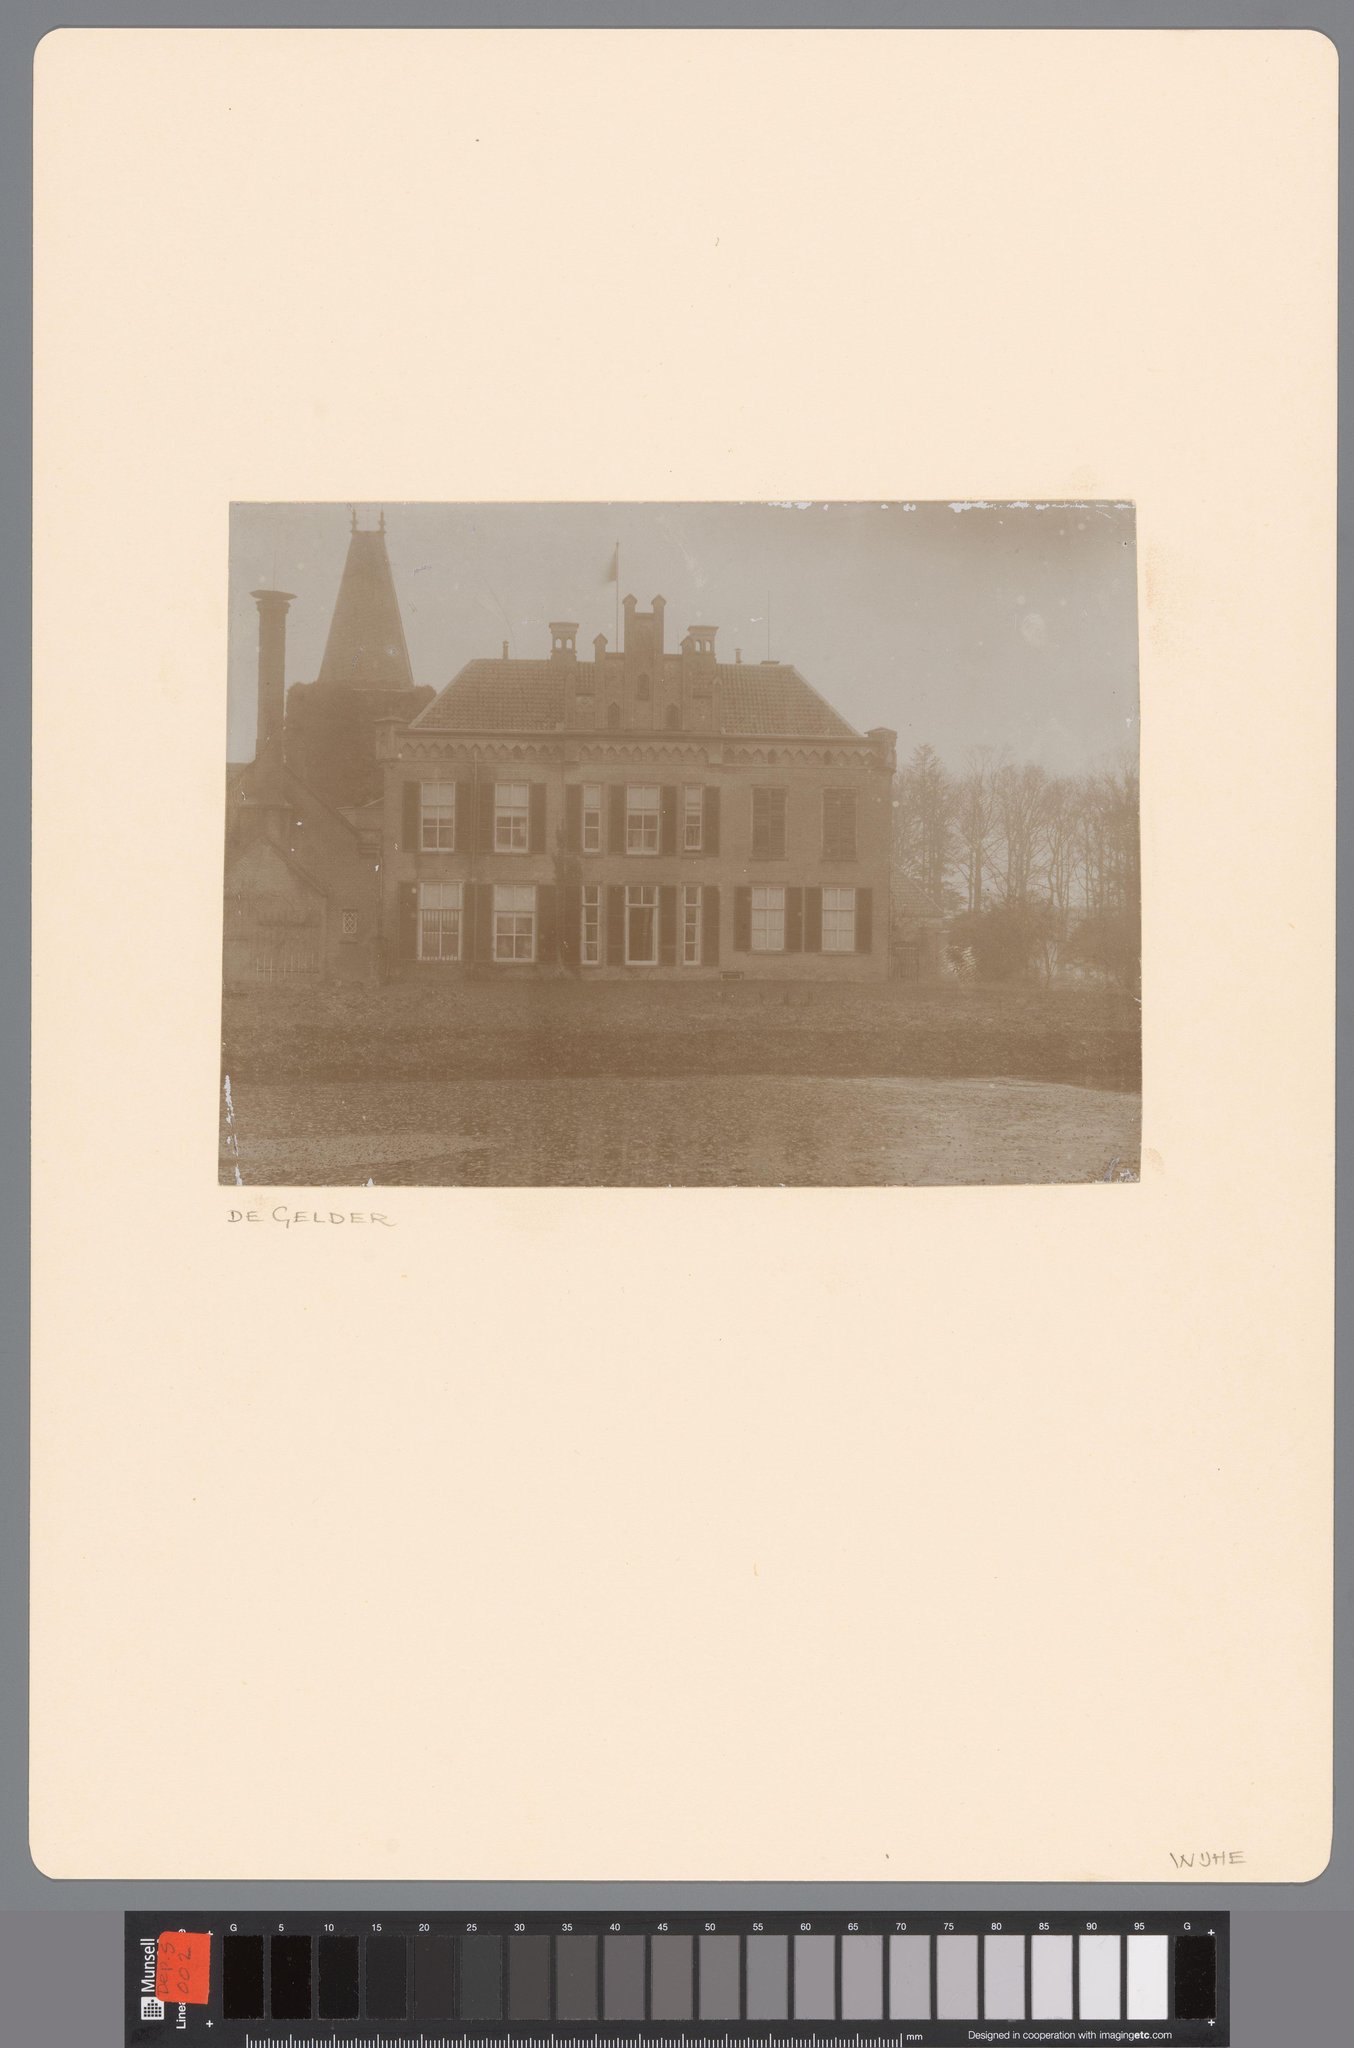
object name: photograph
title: Achtergevel van havezate De Gelder te Wijhe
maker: anoniem (monumentenzorg)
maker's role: fotograaf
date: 1910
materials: cardboard, photographic support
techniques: collodion silver print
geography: wijhe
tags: castle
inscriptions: annotation: ‘Achtergevel van het kasteel de Gelder 1850 te Wijhe/ Dec 1910’, annotation: ‘De Gelder/ Wijhe’